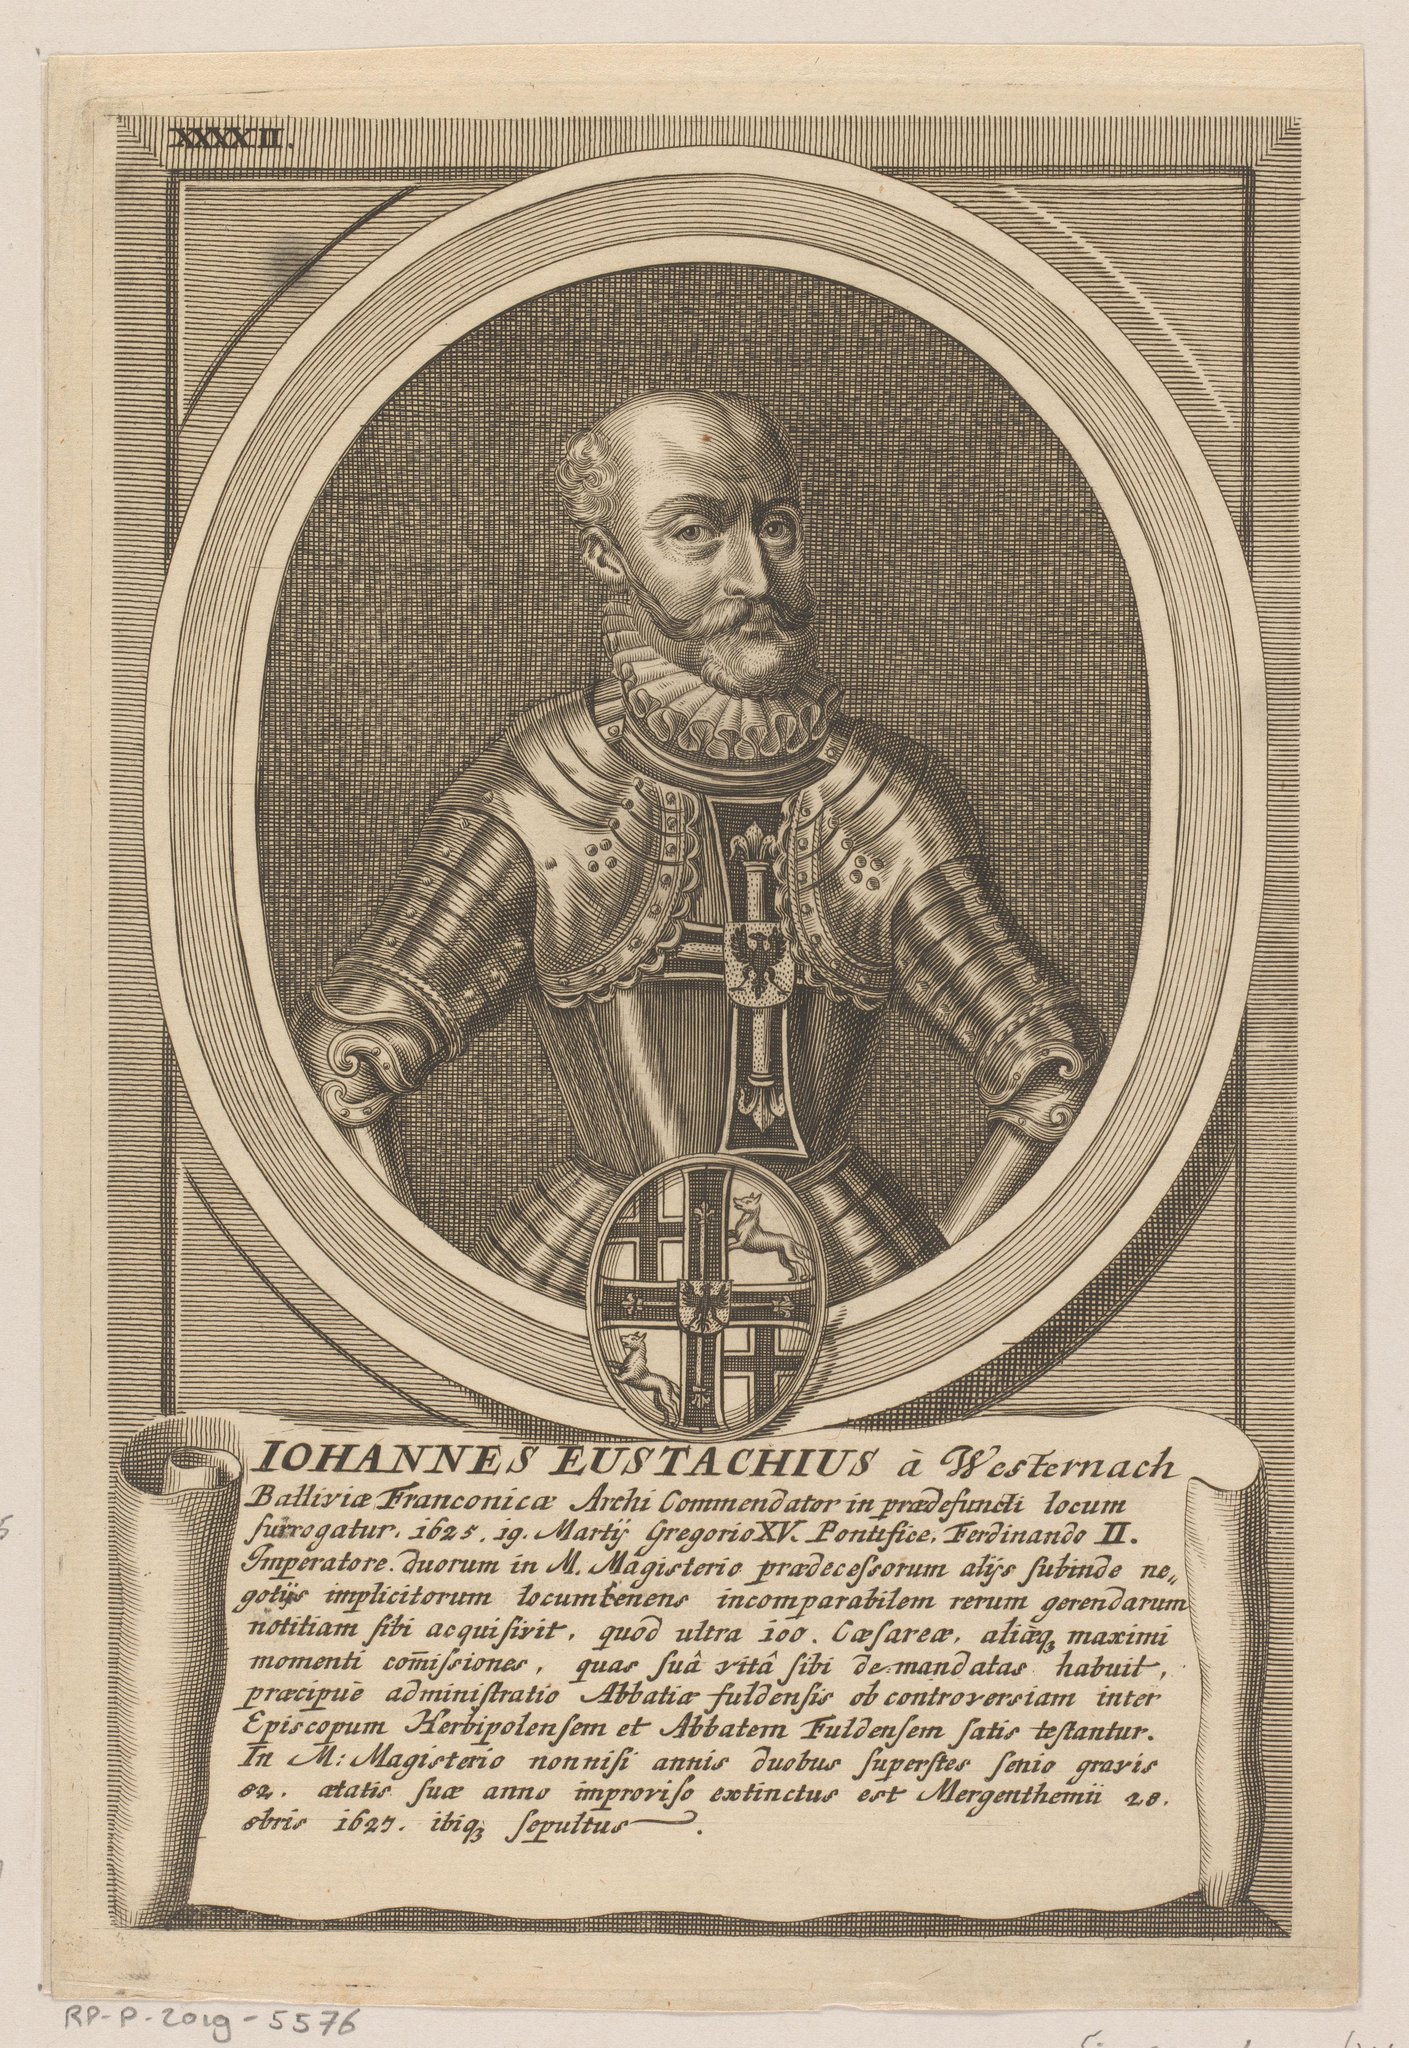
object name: print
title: Johannes Eustachius à Westernach (...)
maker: johann salver (i)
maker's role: print maker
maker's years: 1670-1738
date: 1720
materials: paper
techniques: engraving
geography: würzburg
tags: bad mergentheim, politician, knighthood order: teutonic order - insignia of a knighthood order, e.g.: badge, chain (with name of order), armour, historical persons, armorial bearing, heraldry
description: Prent uit: [Salver, Johann]. De origine, secundis et adversis successibus, nec non de statu moderno inclyti ordinis equestris hospitalis b.m.v. Teutonicorum in Jerusalem. Würzburg: Johann Salver, [ca. 1720].